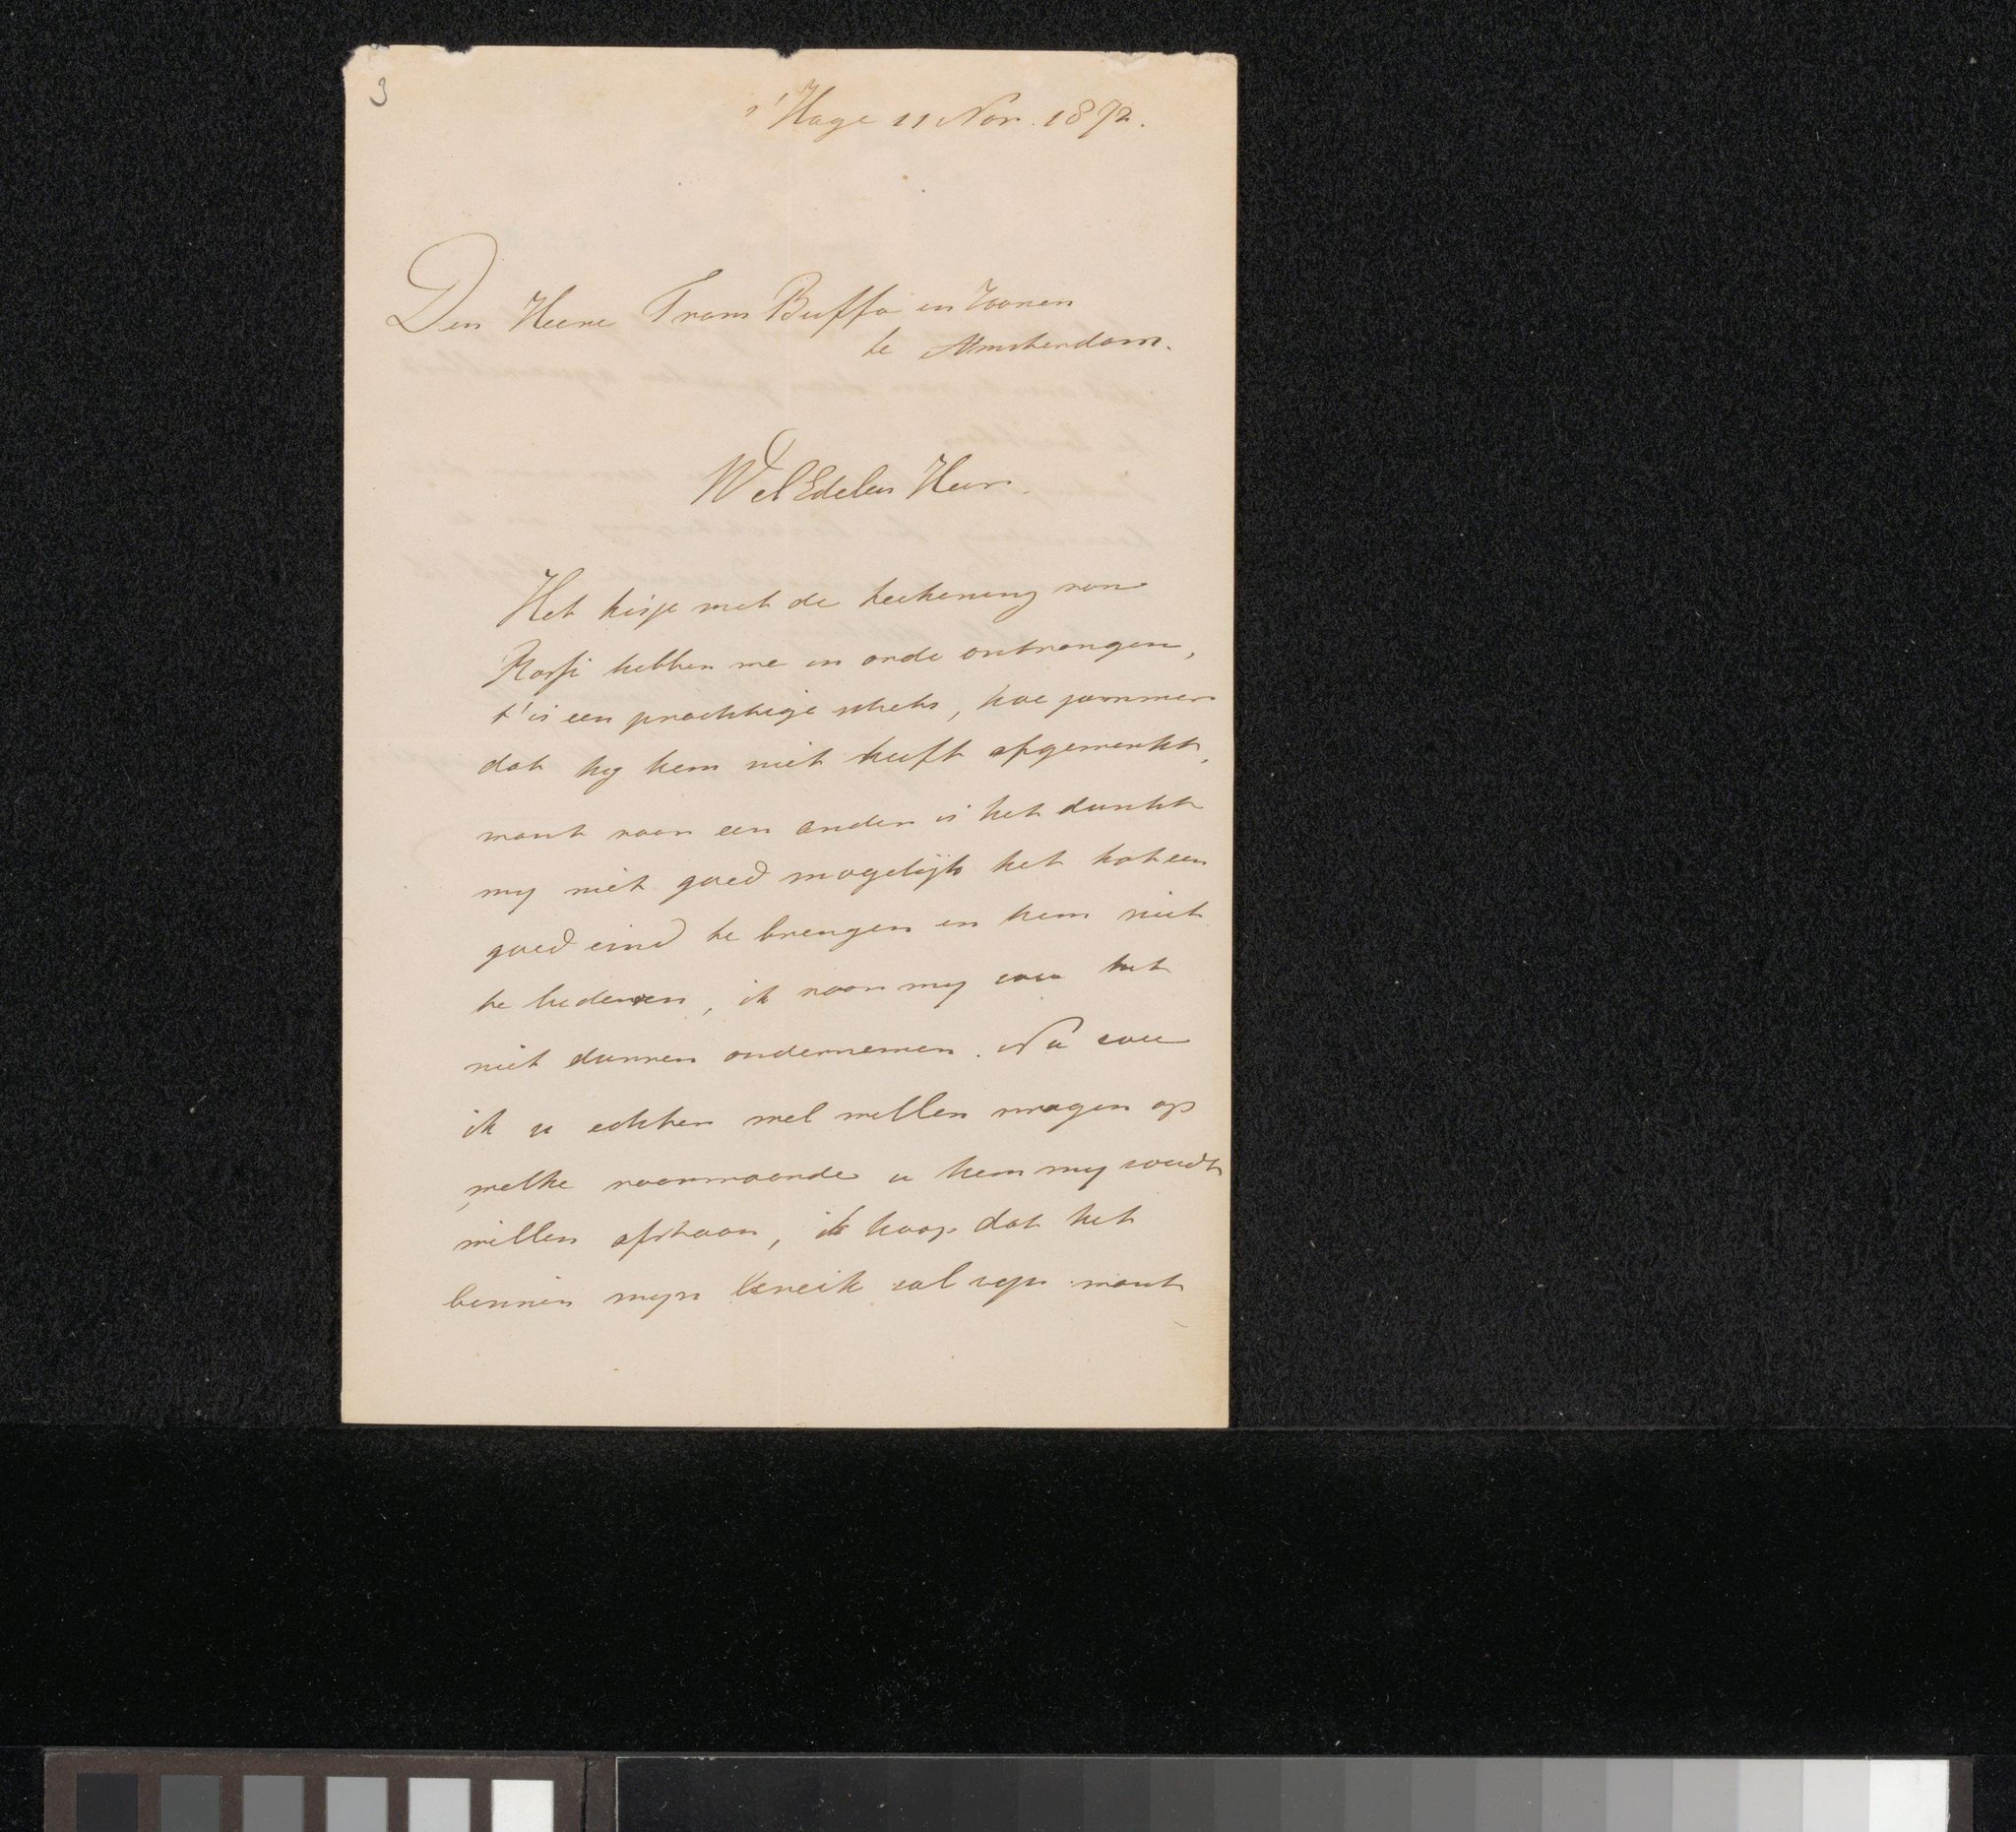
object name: letter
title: Brief aan Frans Buffa en Zonen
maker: gerardine jacoba van de sande bakhuyzen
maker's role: draughtsman, painter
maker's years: 1826-1895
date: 1872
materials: ink, paper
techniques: pen, writing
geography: the hague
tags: publisher, drawing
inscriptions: collector's mark: Lugt 2233